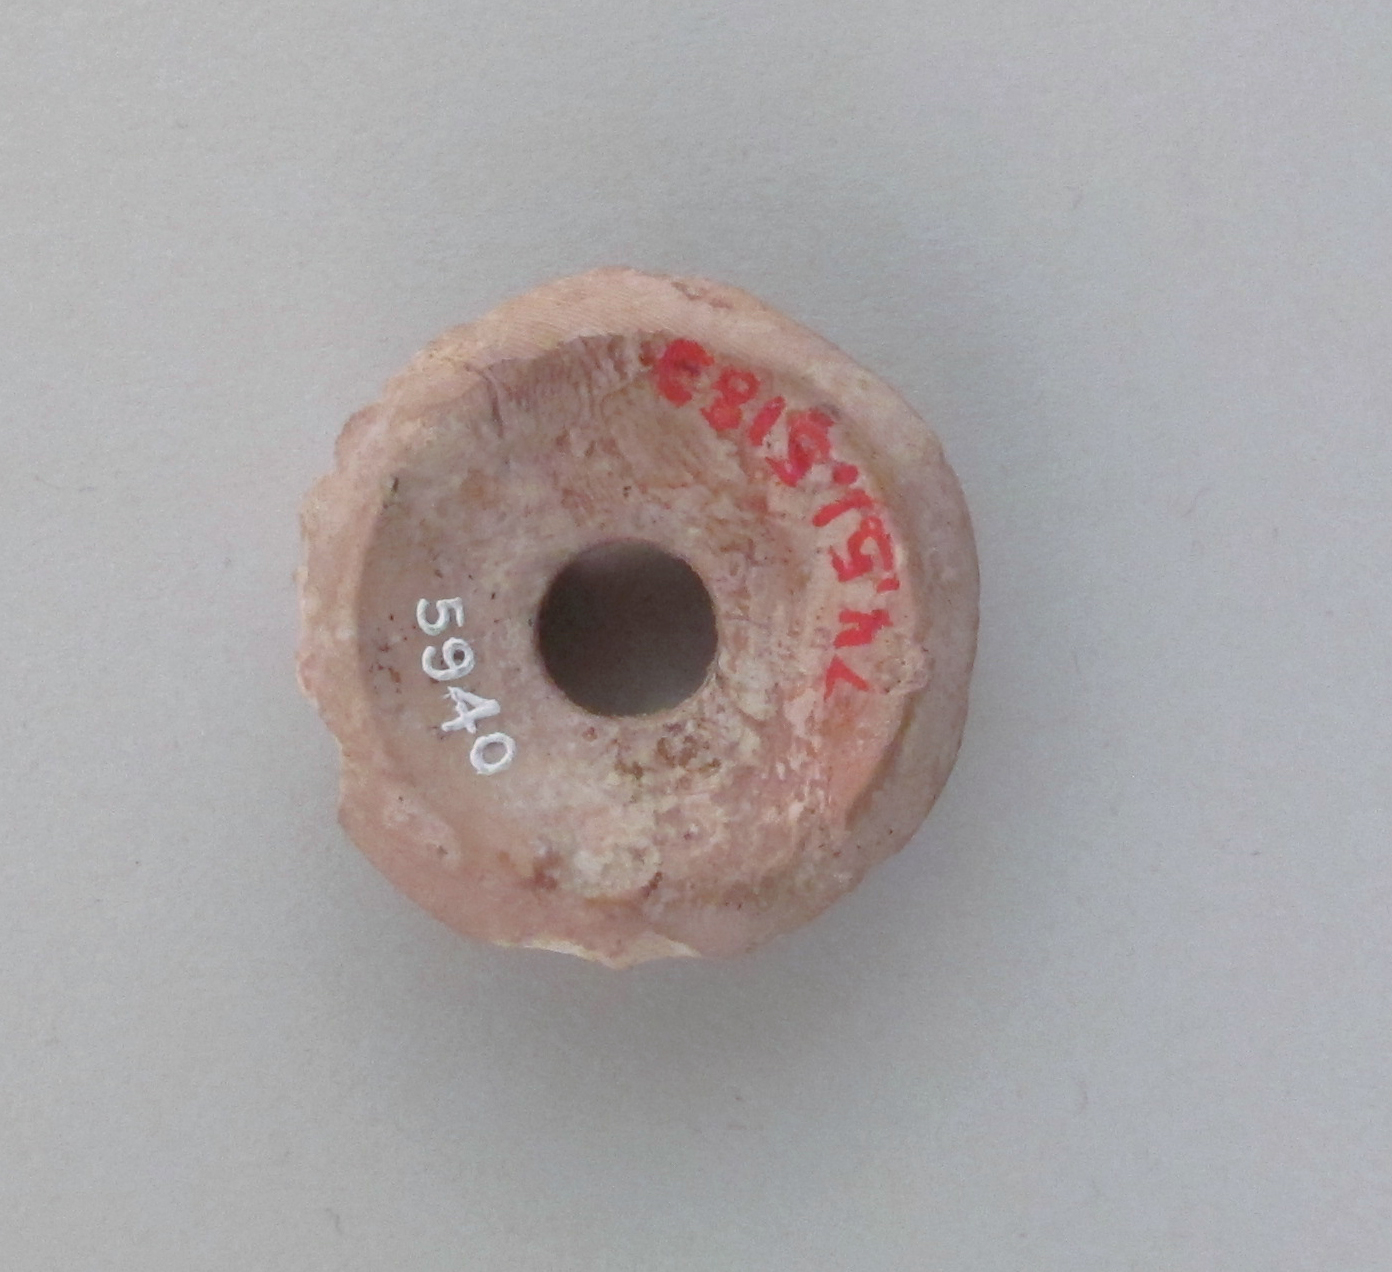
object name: spindle finial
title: Ivory spindle finial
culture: cypriot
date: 1300-1101 BCE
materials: ivory